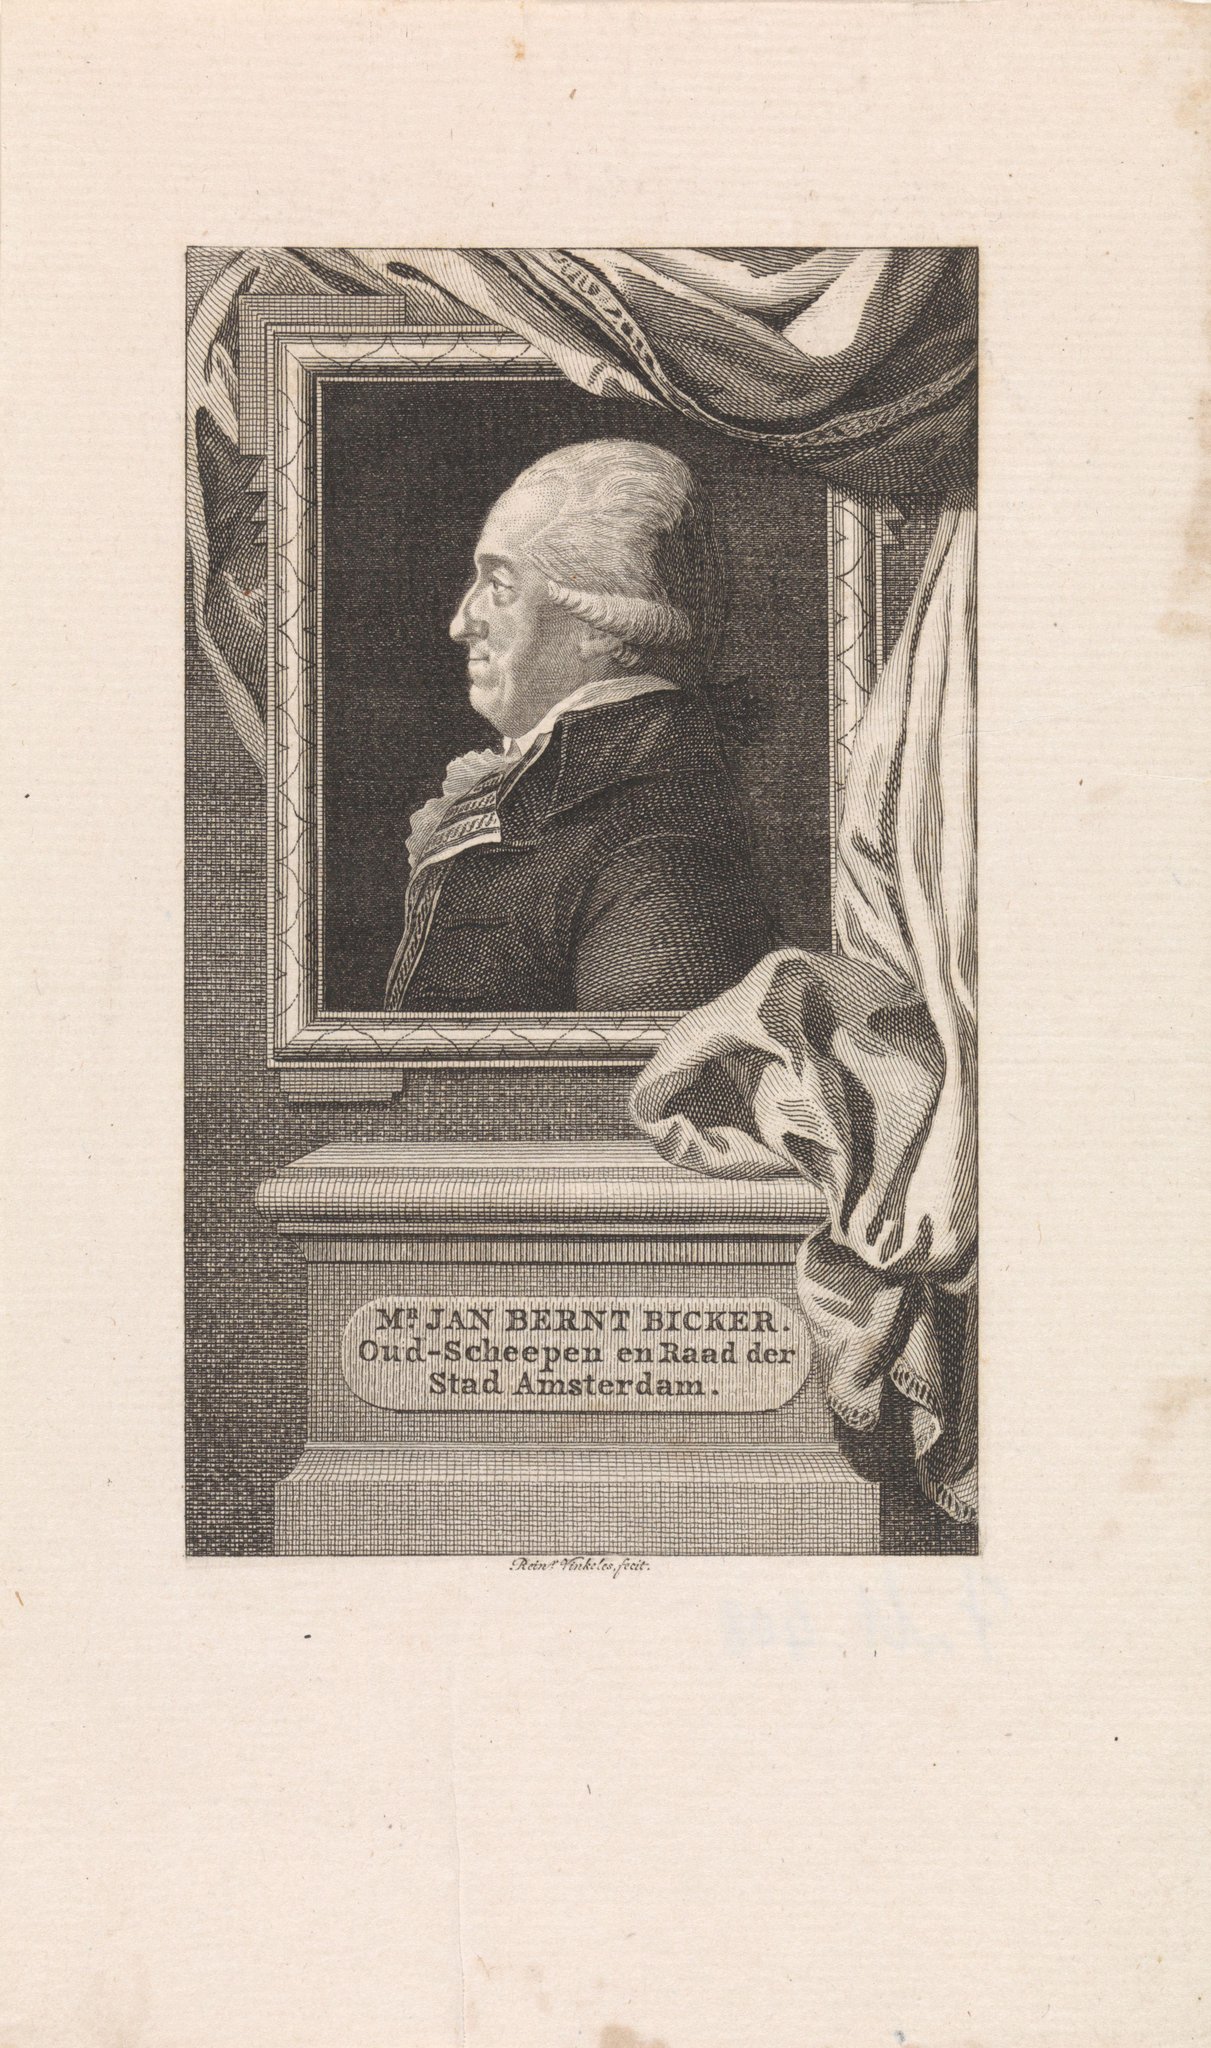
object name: print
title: Portret van Jan Bernd Bicker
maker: reinier vinkeles (i)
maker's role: draughtsman, print maker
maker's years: 1741-1816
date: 1786-1809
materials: paper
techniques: engraving, etching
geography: amsterdam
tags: the hague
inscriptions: collector's mark: Lugt 2228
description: Prent ook gebruikt als boekillustratie in: Wagenaar, Jan. Vaderlandsche historie, (...) ten vervolge van Wagenaars Vaderlandsche historie. Dl. 1-43. Amsterdam: Johannes Allart, 1786-1809.